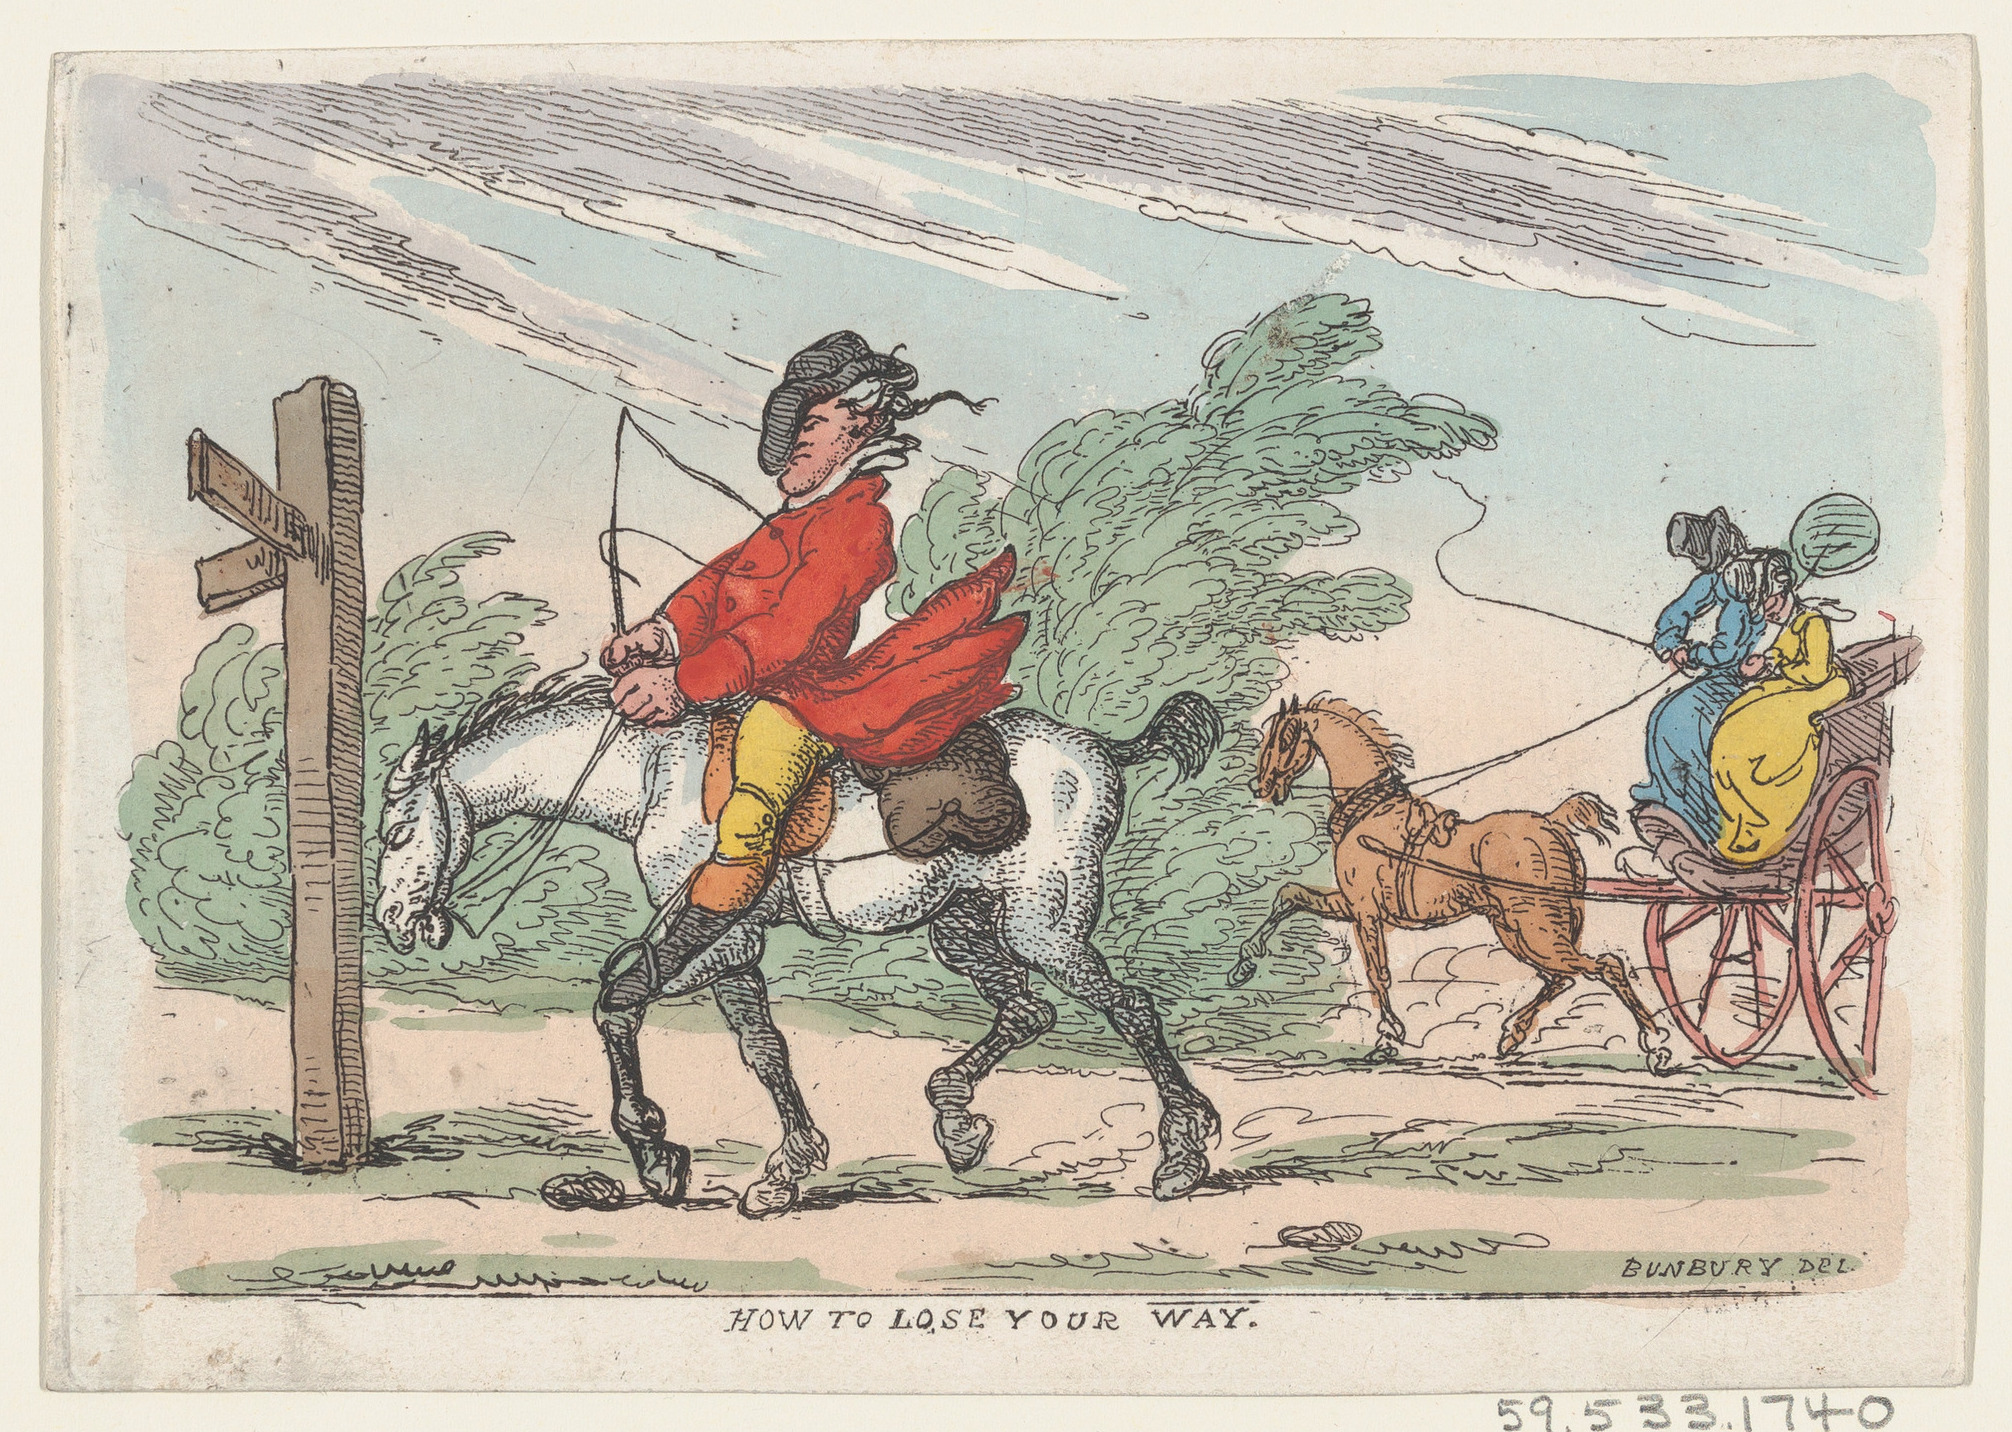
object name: print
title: How to Lose Your Way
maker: thomas rowlandson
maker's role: artist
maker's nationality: british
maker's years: 1757-1827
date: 1803-1815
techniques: etching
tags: satire,men,women,horses,wind,carriages